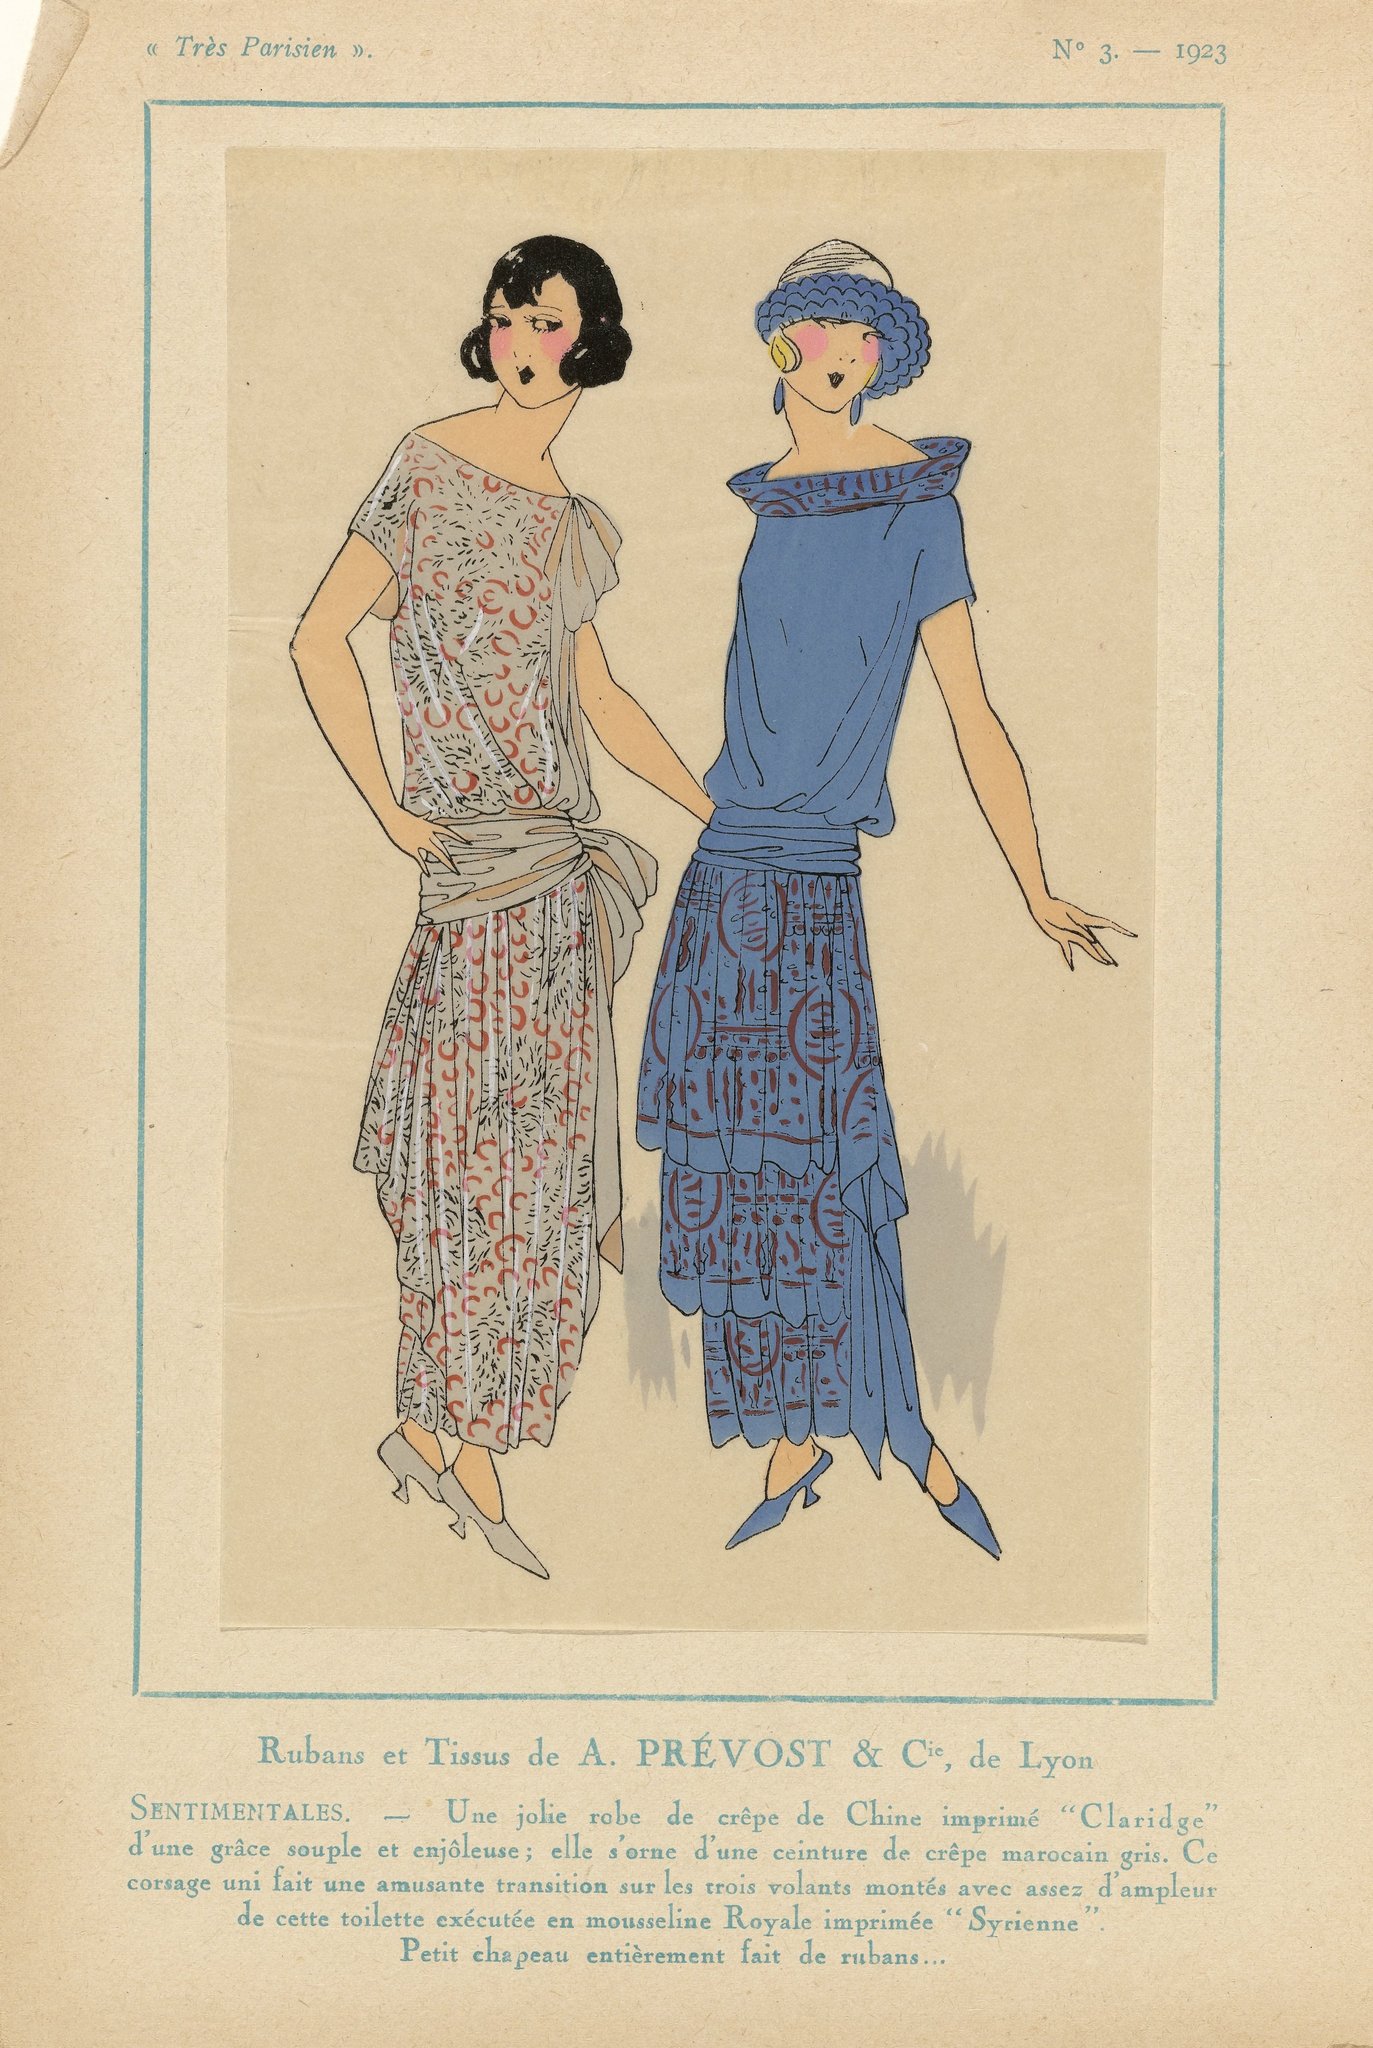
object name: fashion print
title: Très Parisien, 1923, No. 3: Rubans et Tissus de A. PRÉVOST...SENTIMENTALES...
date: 1923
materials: paper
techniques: hand coloring, letterpress printing, lithography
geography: paris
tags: border, ribbon, braid (+ women's clothes), fashion plates, head-gear: hat (+ women's clothes), dress, gown (+ women's clothes), belt, girdle, waistband (+ women's clothes)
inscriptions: caption: ‘Rubans et Tissus de A. PRÉVOST & CIE ,de Lyon / SENTIMENTALES. - Une jolie robe de crêpe imprimé "Claridge" d'une grâce souple et enjôleuse; elle s'orne d'une ceinture de crêpe marocain gris. Ce corsage uni fait une amusante transition sur les trois volants montés avec assez d'ampleur de cette toilette exécutée en mousseline Royale imprimée "Syrienne". Petit chapeau entièrement fait de rubans...’, title: ‘Très Parisien / No 3. - 1923’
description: Linten en stoffen van A. Prévost & Cie. Een jurk van bedrukte 'crêpe de Chine' "Claridge" versierd met een ceintuur van grijze 'crêpe marocain'. Jurk met effen lijfje en rok met drie volants van bedrukte mousseline Royale "Syrienne". Kleine hoed volledig gemaakt van linten. Prent uit het modetijdschrift Très Parisien (1920-1936).